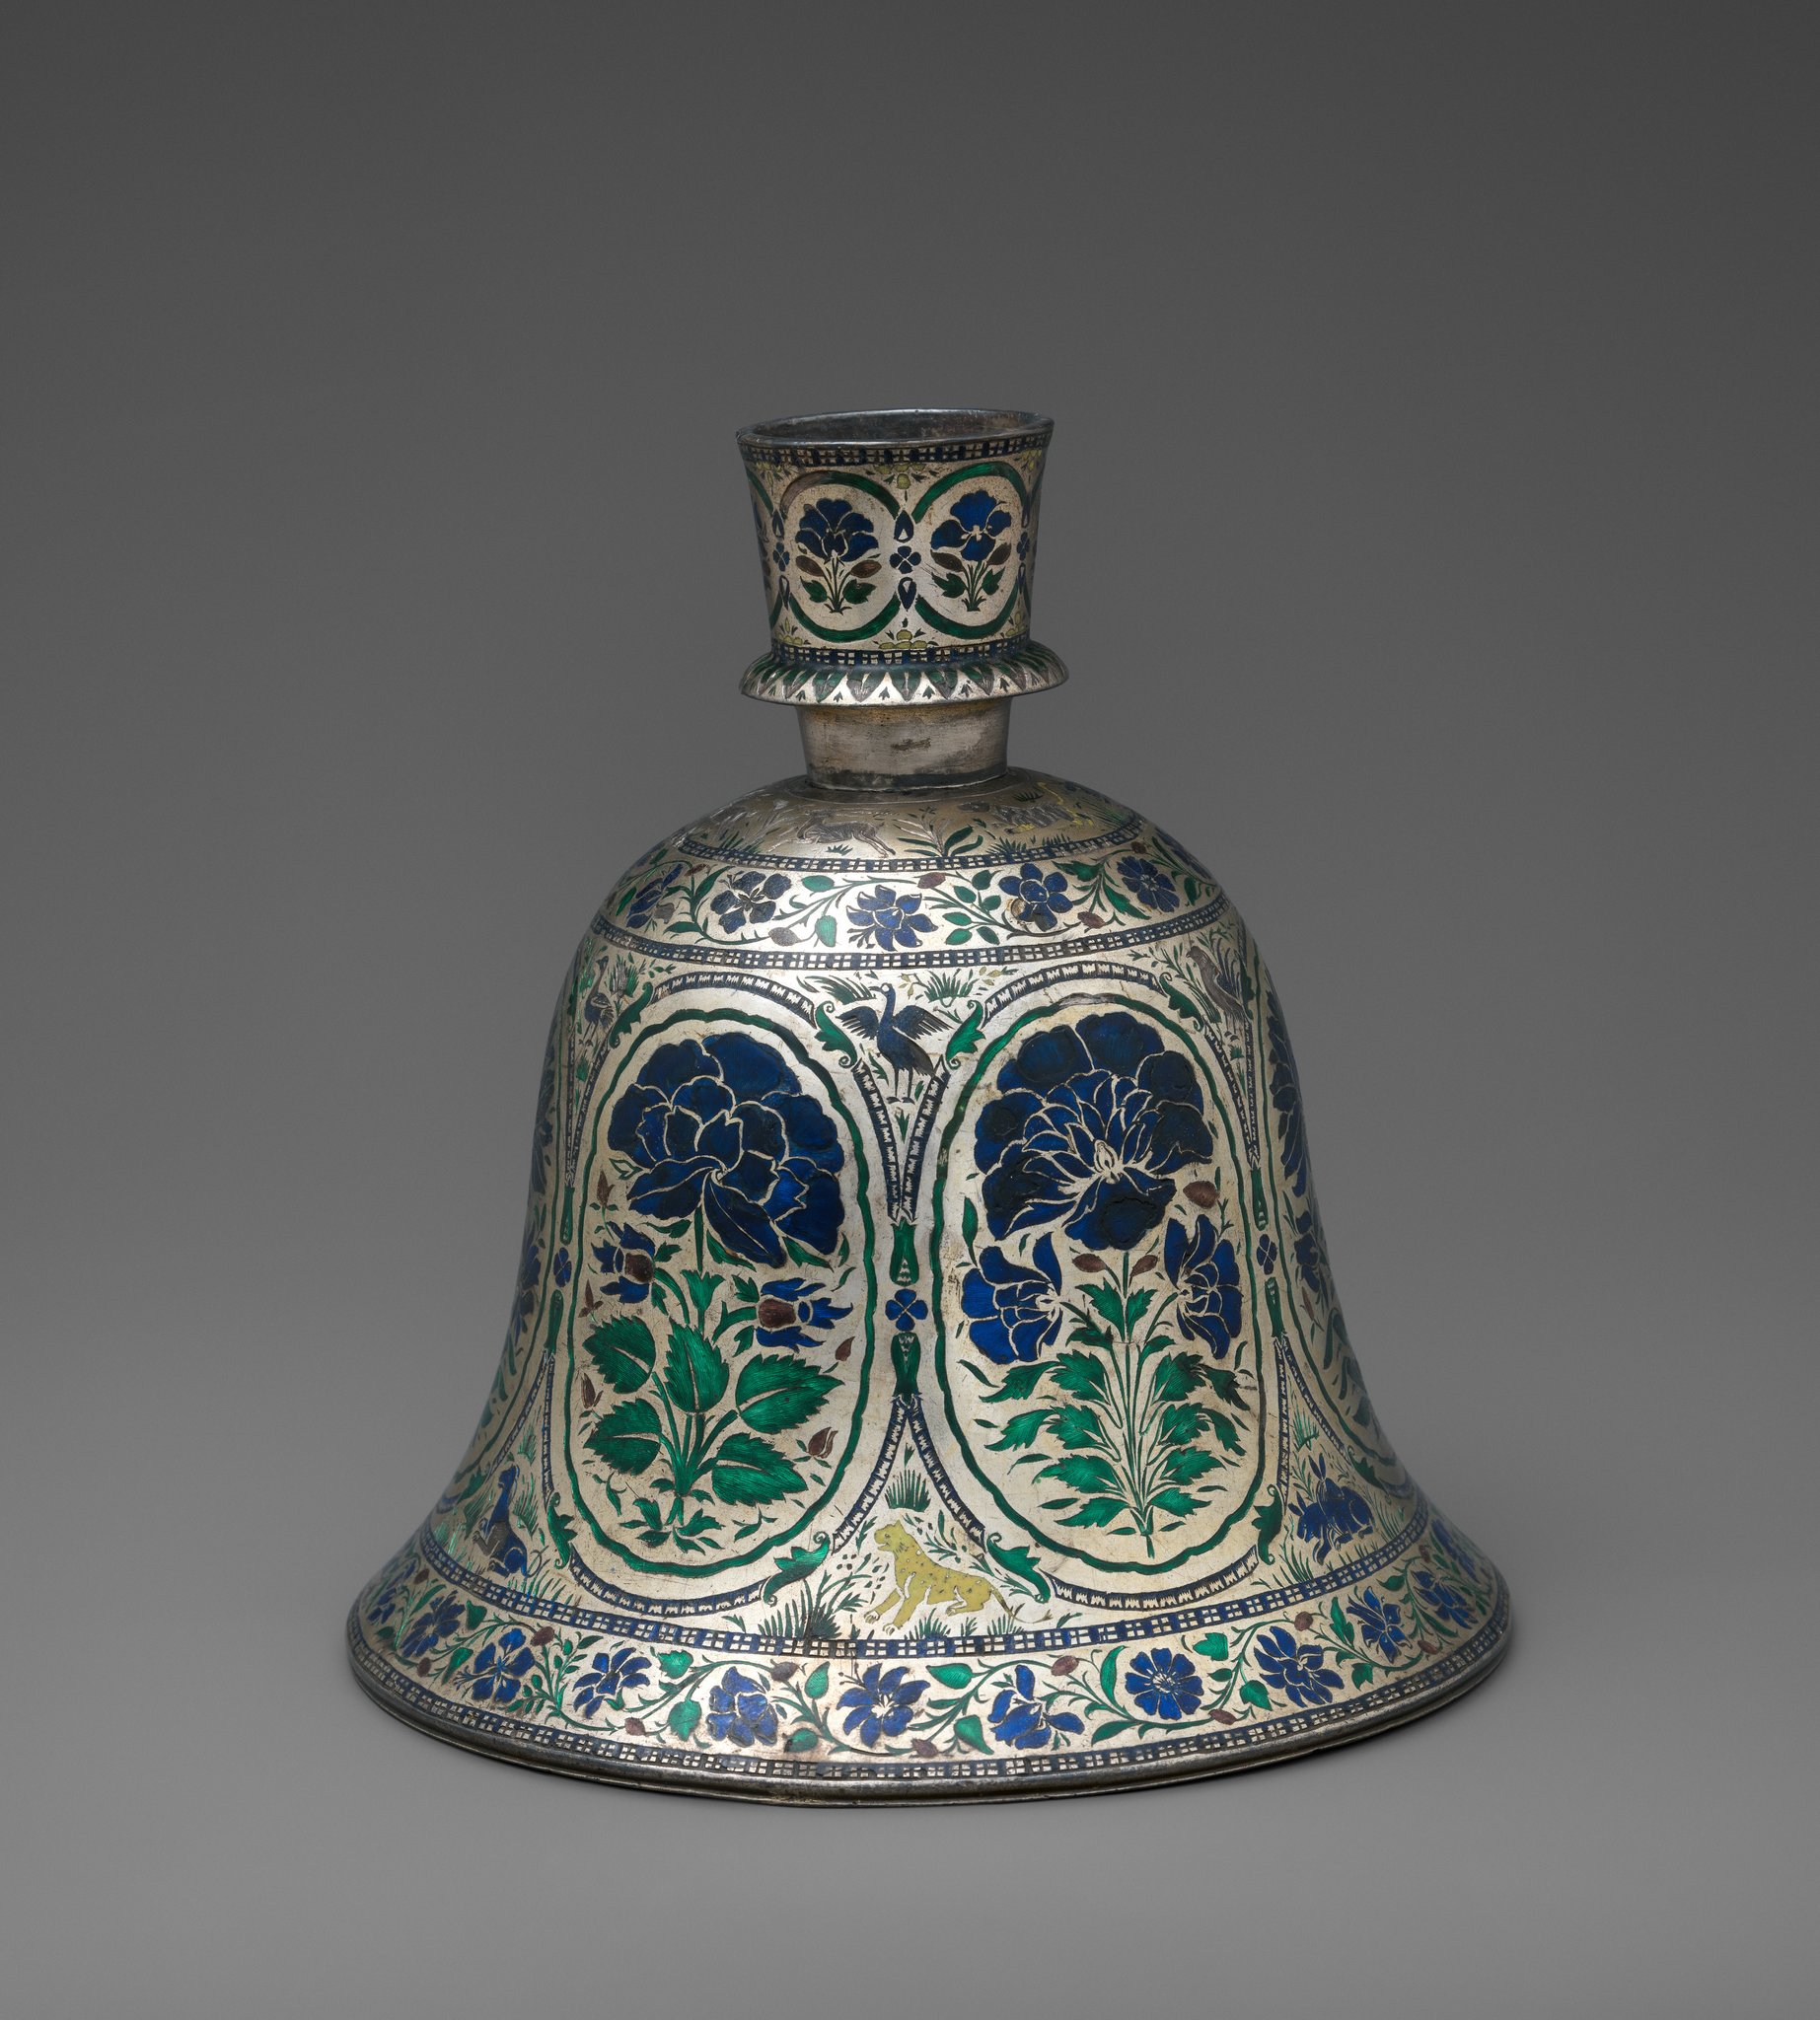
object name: huqqa base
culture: indian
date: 1834-1866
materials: enamel, silver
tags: animals,birds,flowers